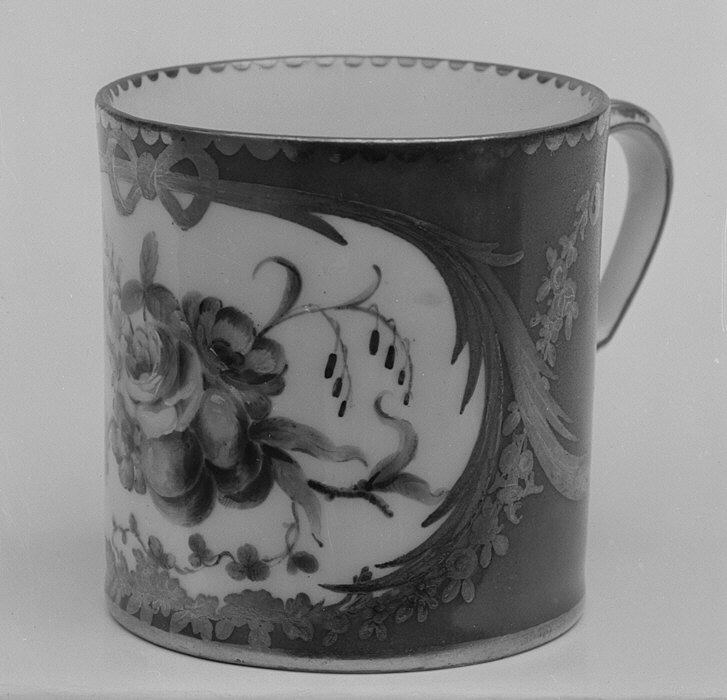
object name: cup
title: Cup (gobelet litron) (one of nine) (part of a a service)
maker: sèvres manufactory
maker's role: manufactory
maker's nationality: french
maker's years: 1740-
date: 1787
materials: soft paste porcelain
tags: roses